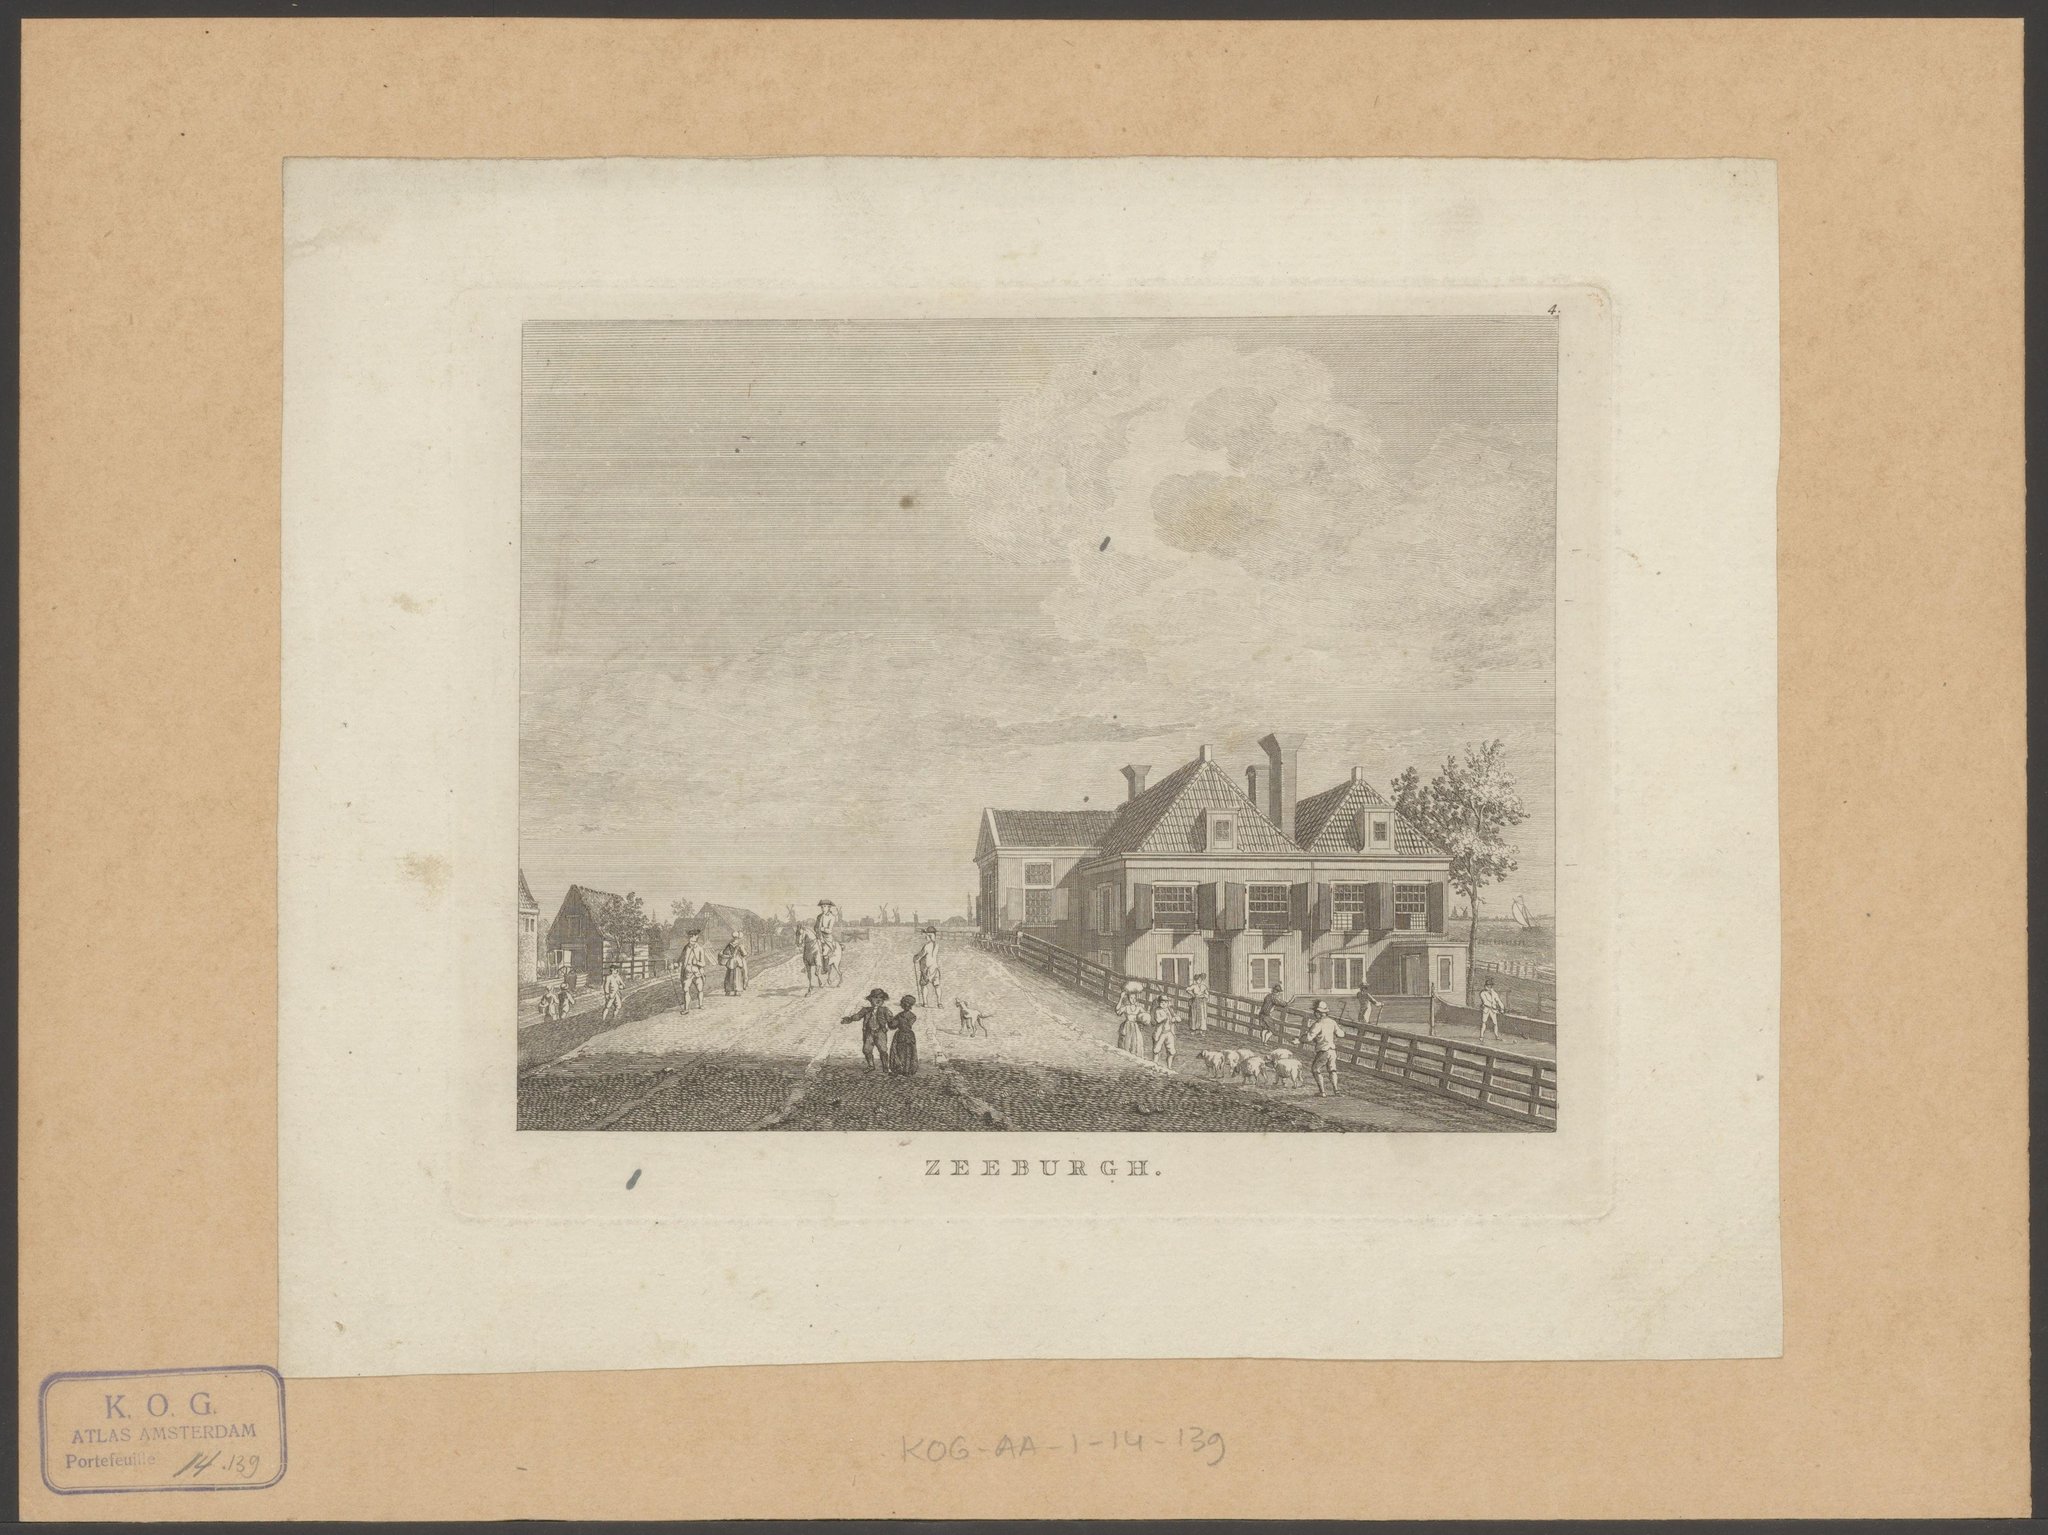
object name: print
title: Gezicht op de herberg Zeeburg op de Zeeburgerdijk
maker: Anonymous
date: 1750-1799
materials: paper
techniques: etching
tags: city-view in general; 'veduta', street, hotel, hostelry, inn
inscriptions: collector's mark: ‘14.139’ Lugt 1641b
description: Onderwerpsrubriek binnen de Atlas Amsterdam: Zaagmolensloot, Zandpad, Zeeburg, Zeeburgerdijk, Zeeburgerpad, Zeeburgerstraat, Zwanenburgwal, Zwartebijlsteeg. Genummerd rechtsboven: 4.